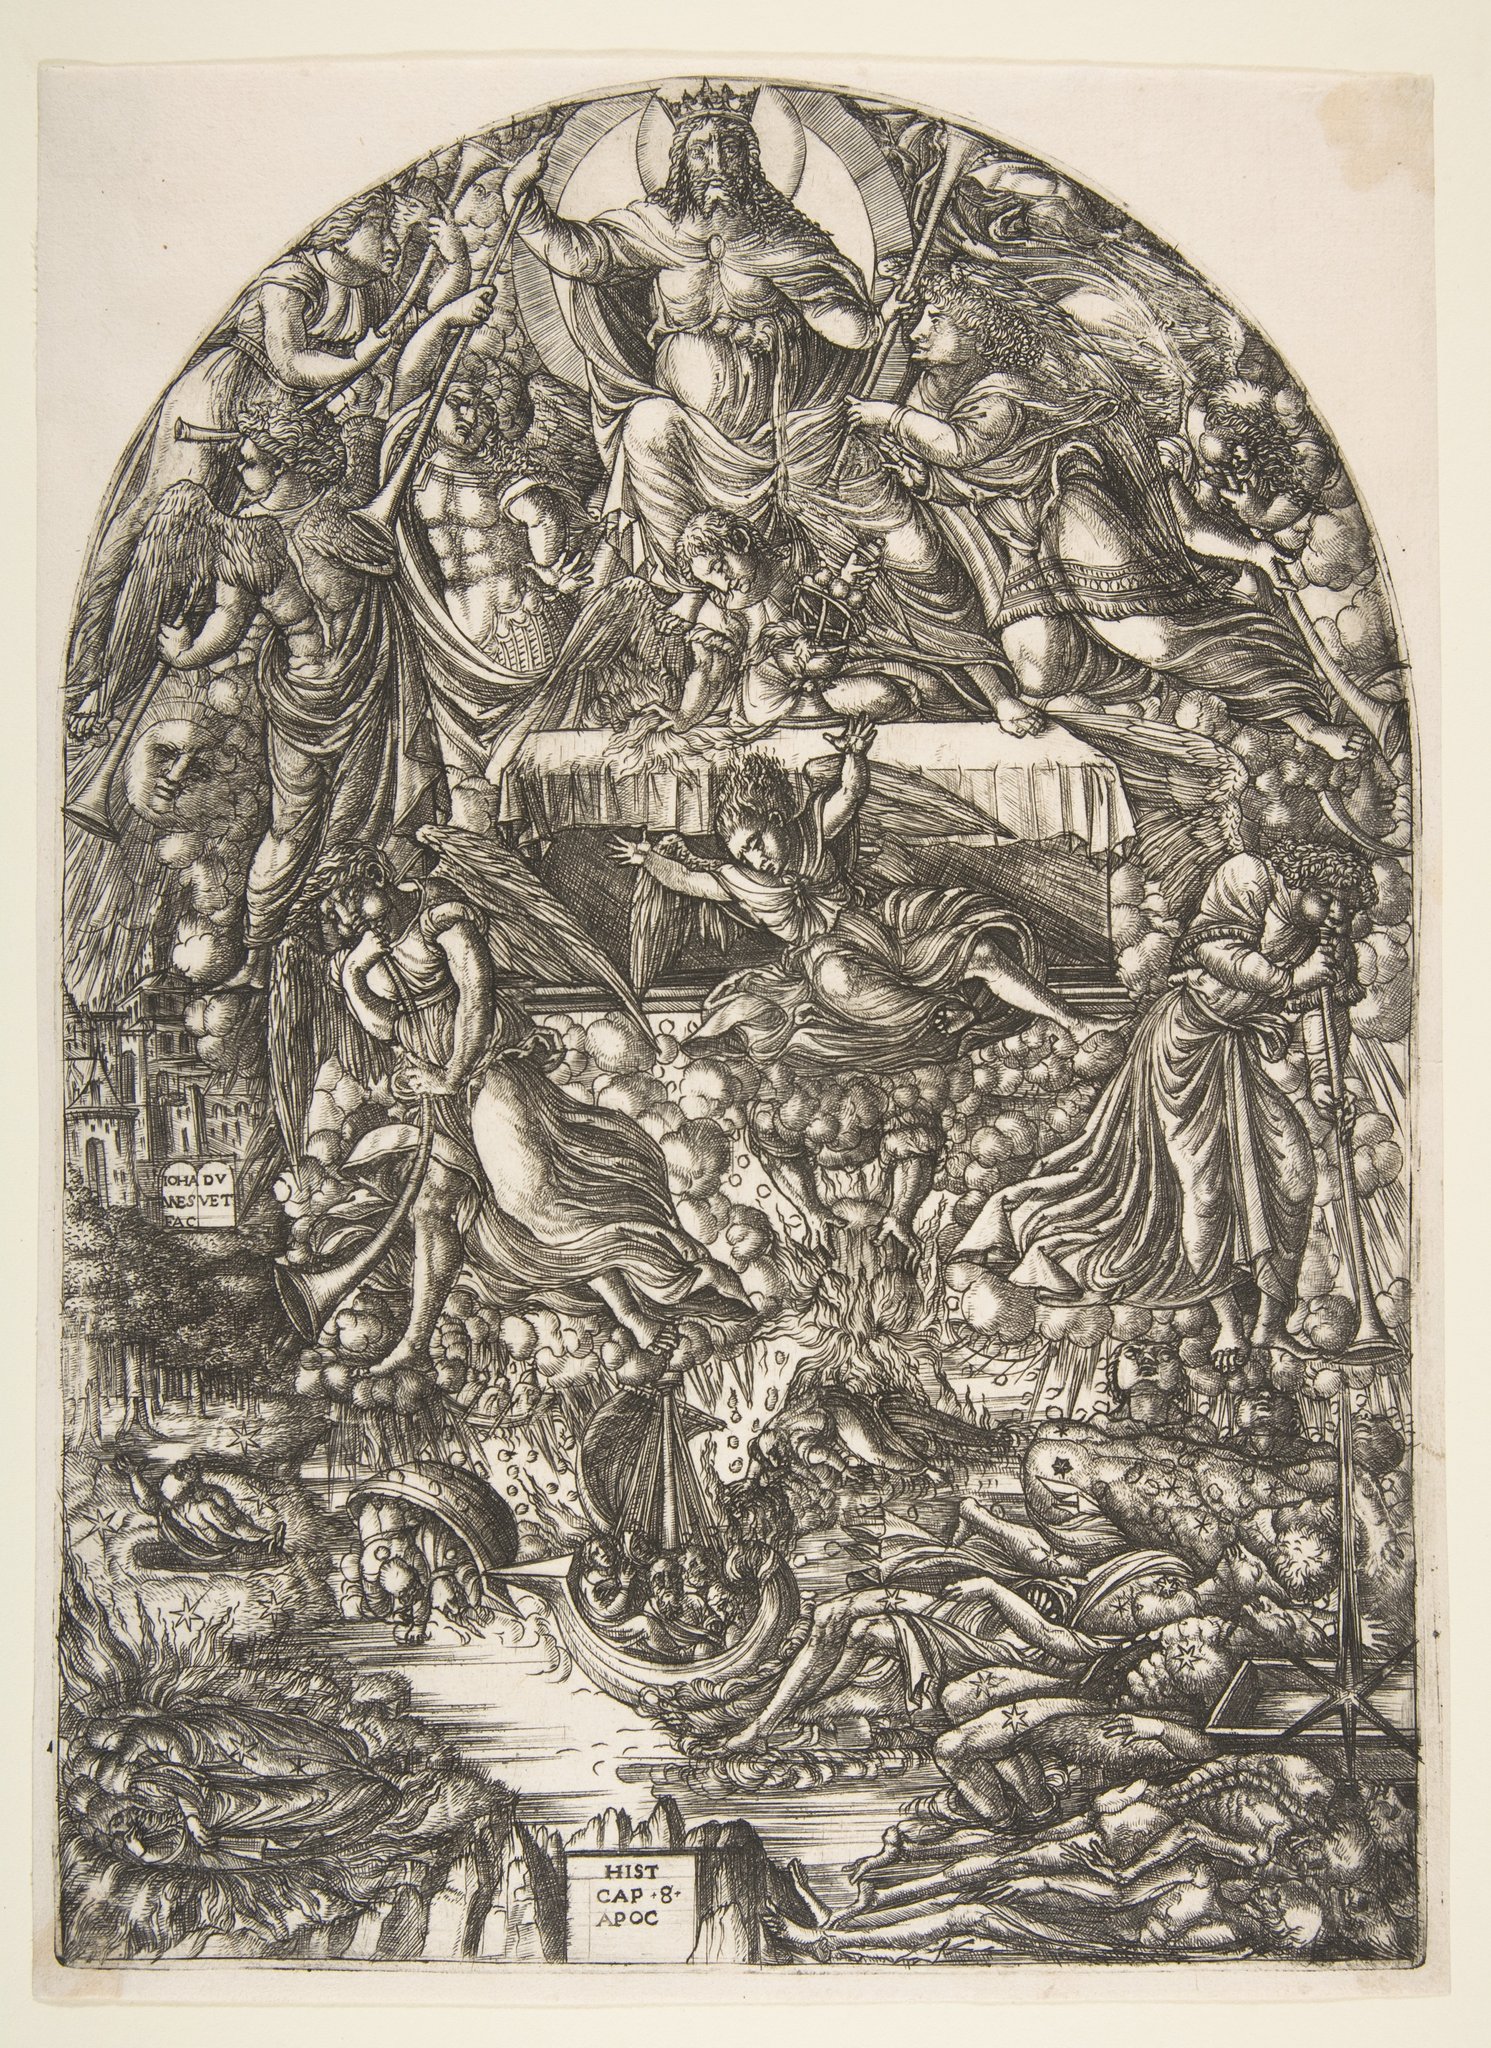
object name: print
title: The Opening of the Seventh Seal, from the Apocalypse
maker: jean duvet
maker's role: artist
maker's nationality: french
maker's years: 1485-1561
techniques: engraving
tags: men,apocalypse